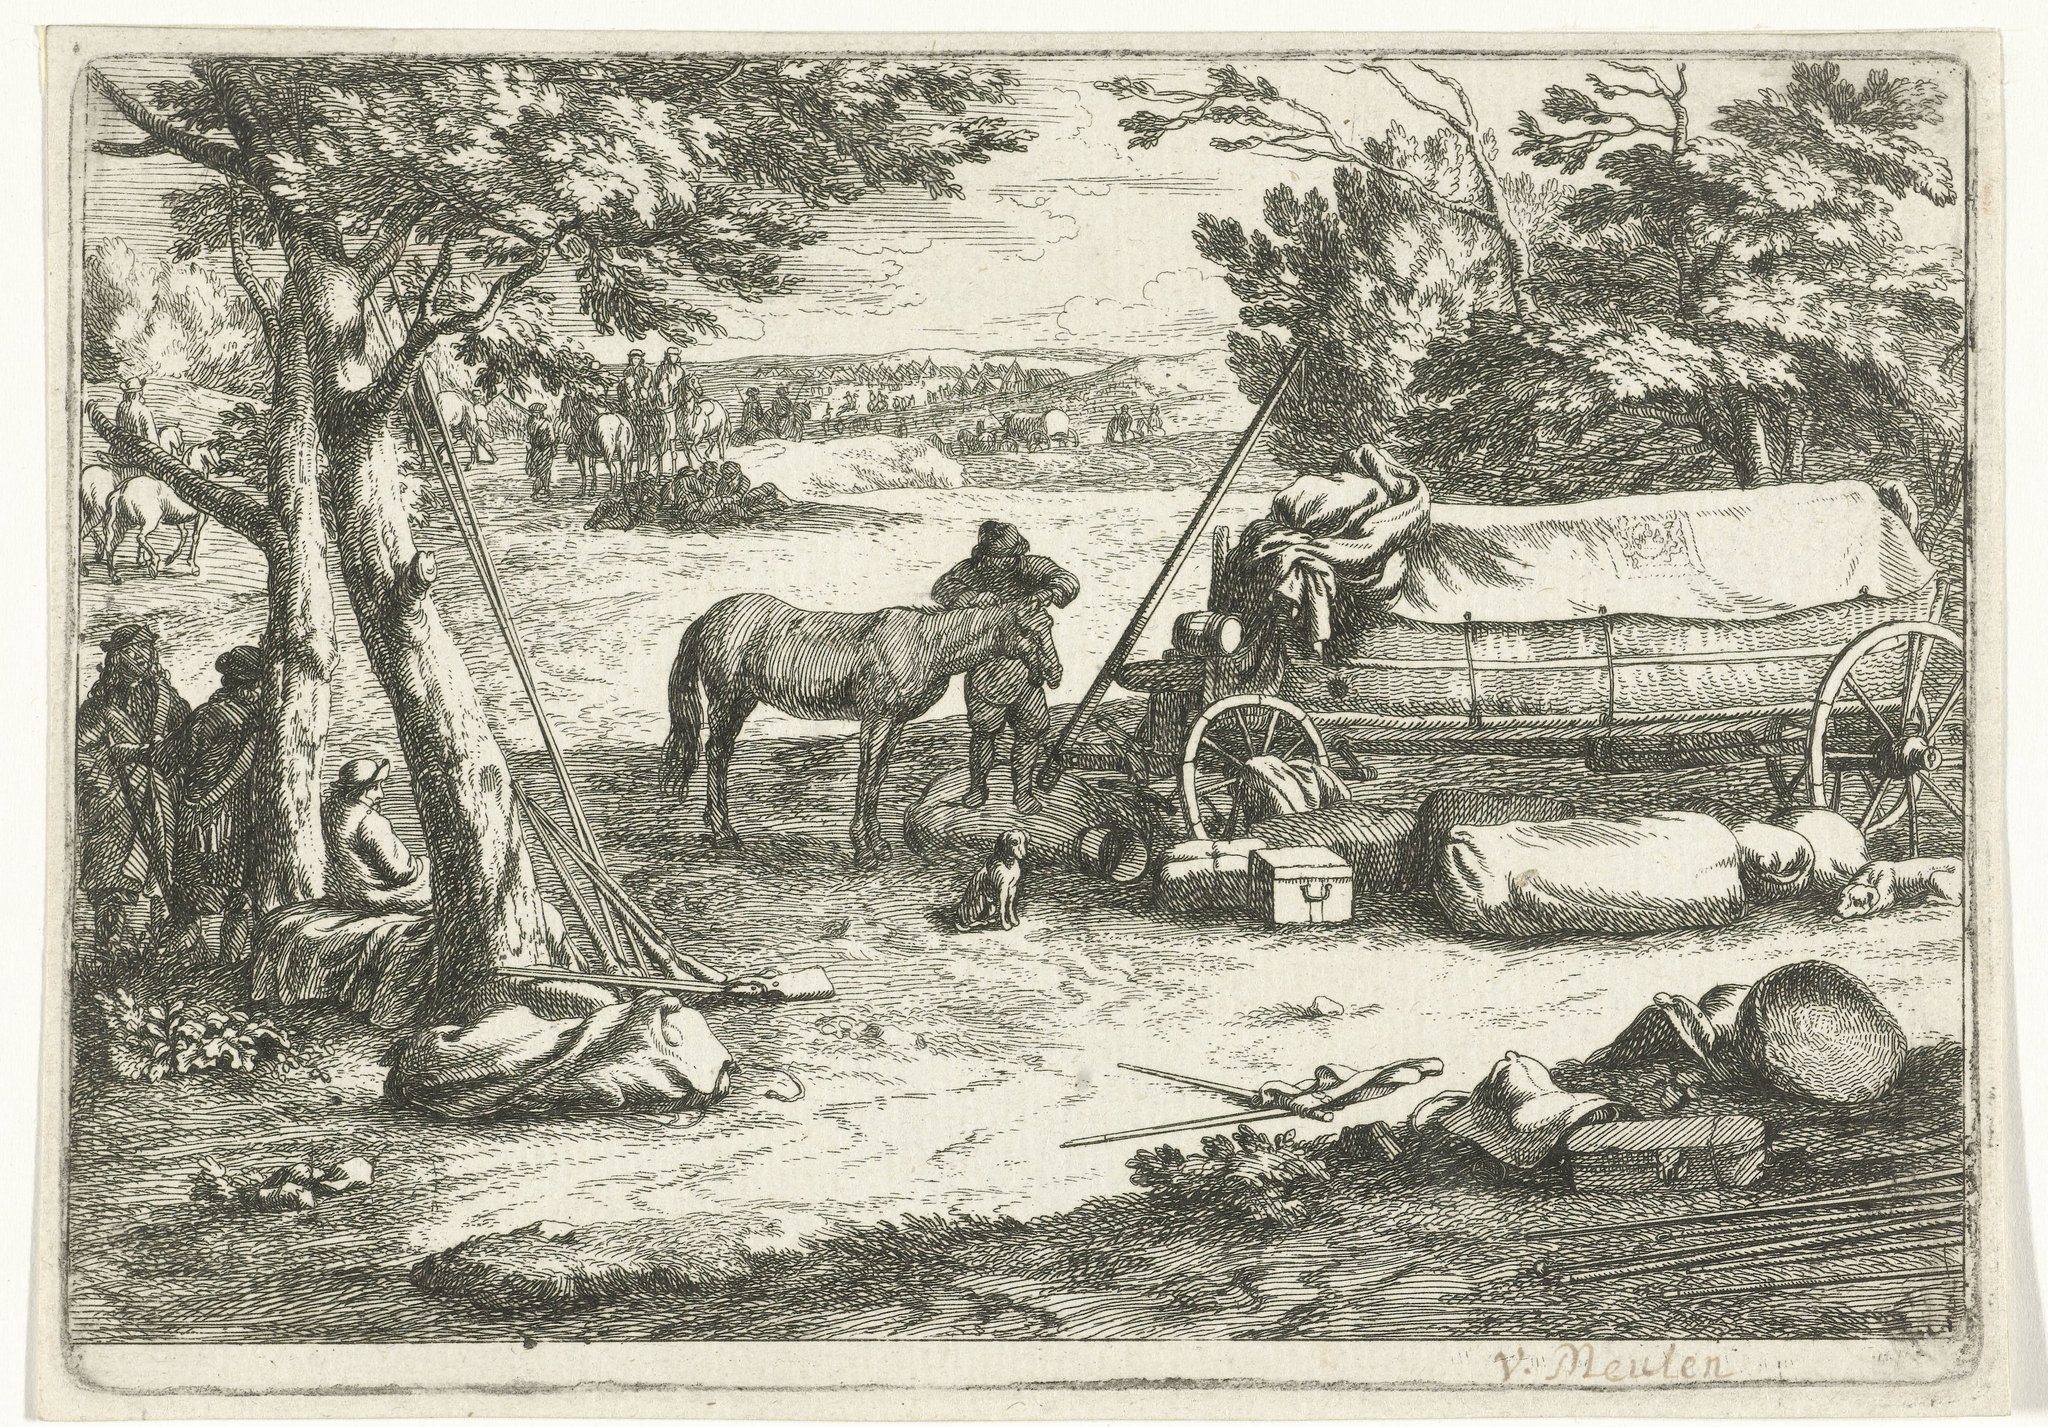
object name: print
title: Landschap met kar en figuren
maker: jan van huchtenburg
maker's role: draughtsman, painter, print maker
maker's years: 1647-1733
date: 1674-1733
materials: paper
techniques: engraving, etching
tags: war and peace (+ cavalry, horsemen)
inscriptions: collector's mark: Lugt 2228, inscription: ‘V. Meulen’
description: Rechts een kar, in het midden een man bij een paard. Links rustende soldaten bij twee bomen, geweren tegen de boom aan. Op de achtergrond cavalerie.